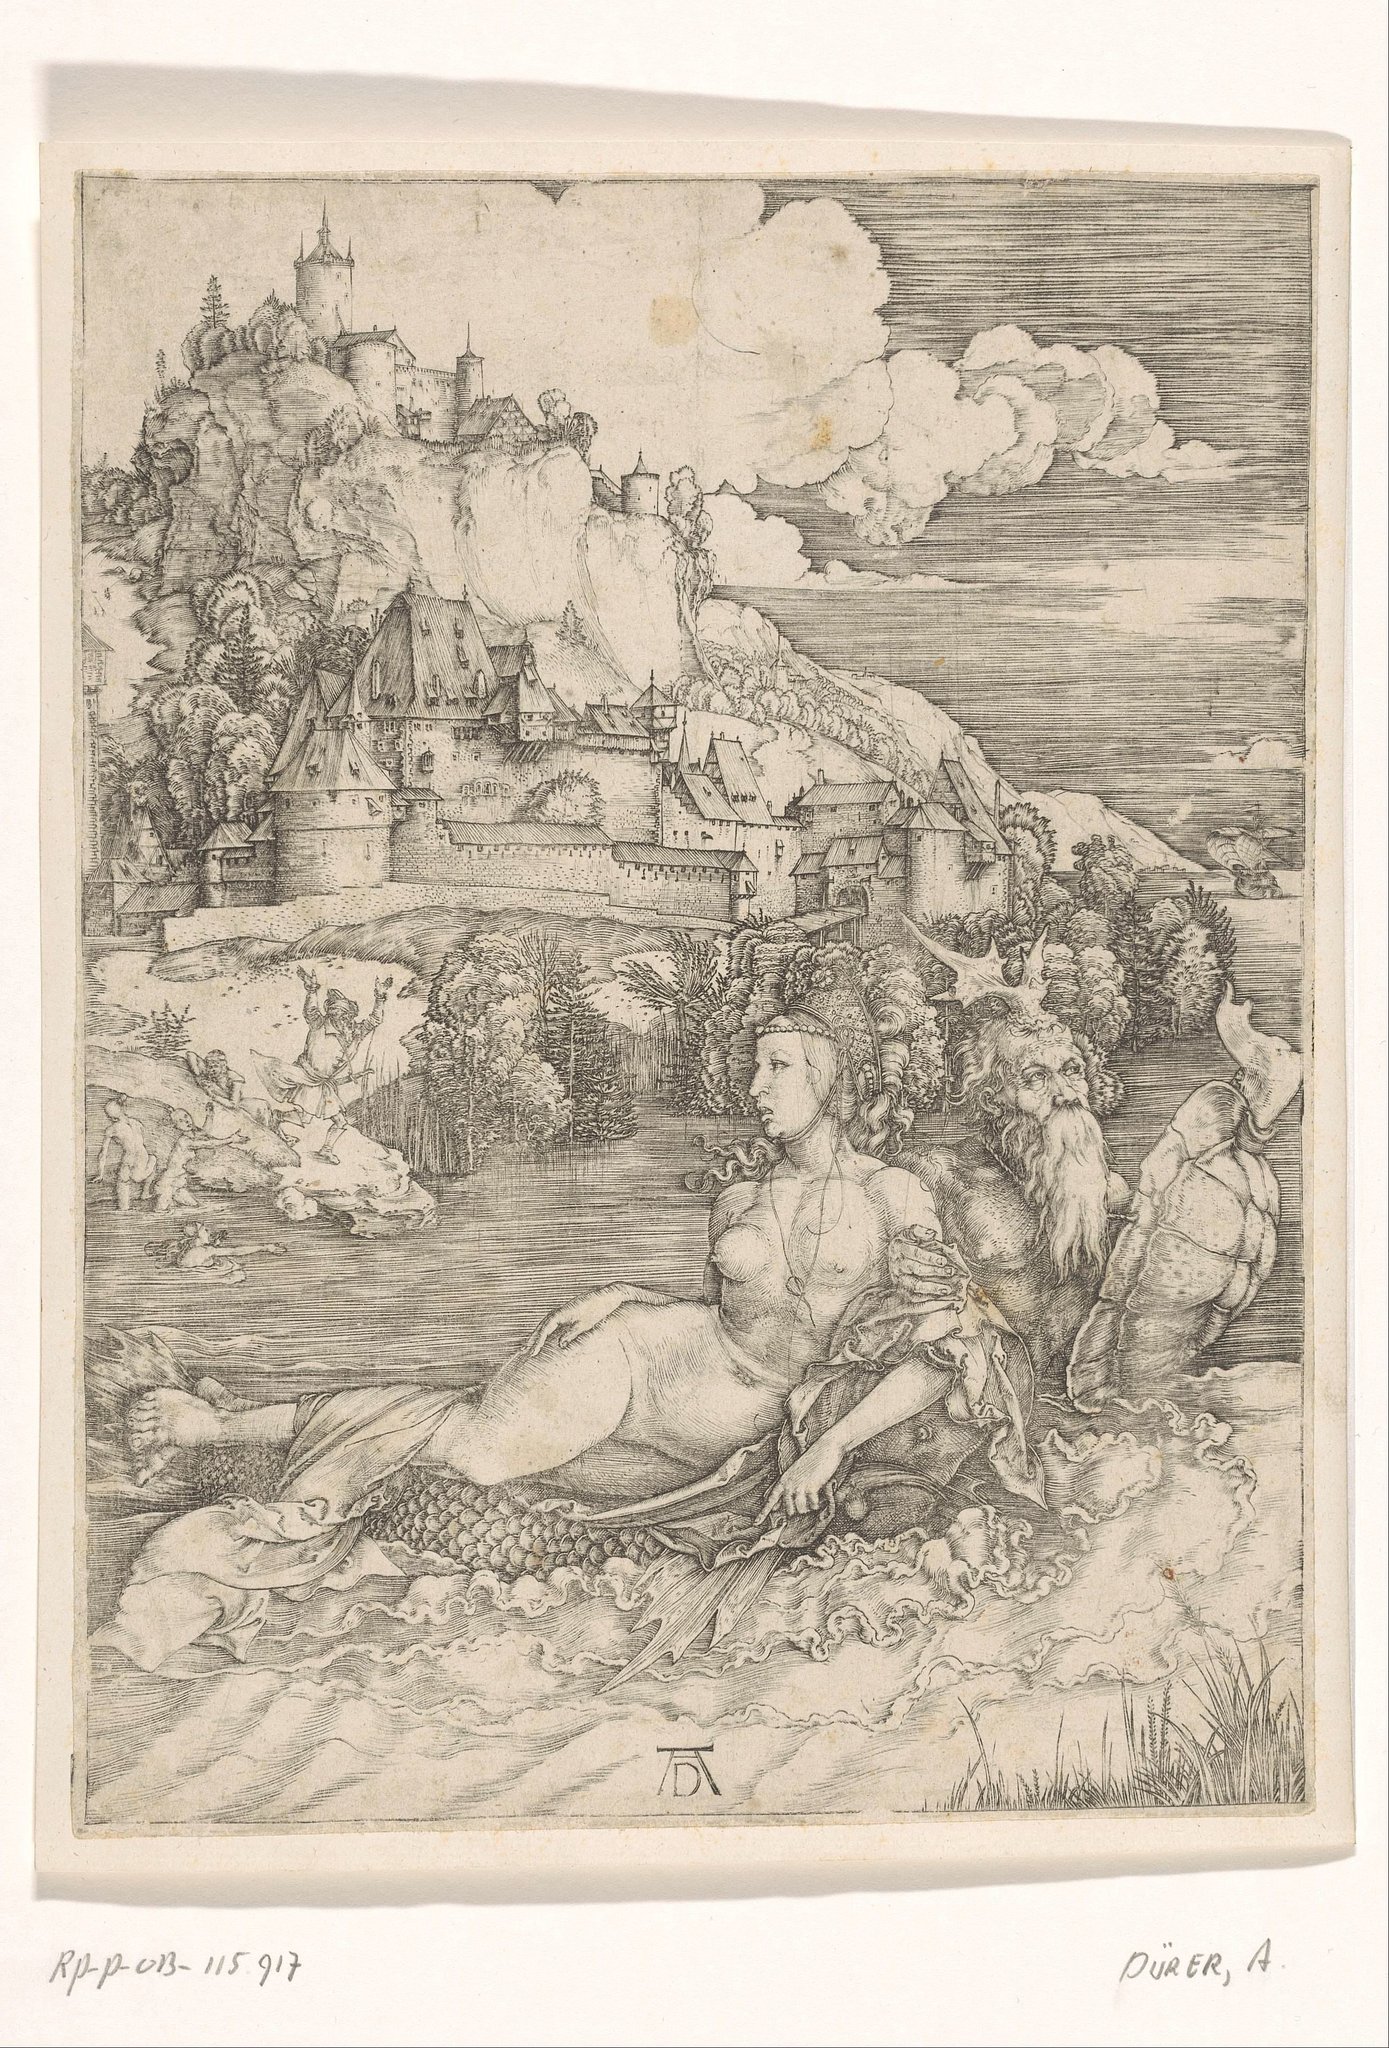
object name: print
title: Ontvoering door het zeemonster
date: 1496-1500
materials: paper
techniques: engraving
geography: nuremberg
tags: woman (showing herself) undressed, quasi-nude, monsters of the sea, abducting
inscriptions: collector's mark: Lugt 2228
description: Links vanaf de kust kijken een man en vier vrouwen toe hoe een naakte vrouw door een zeemonster wordt meegevoerd.